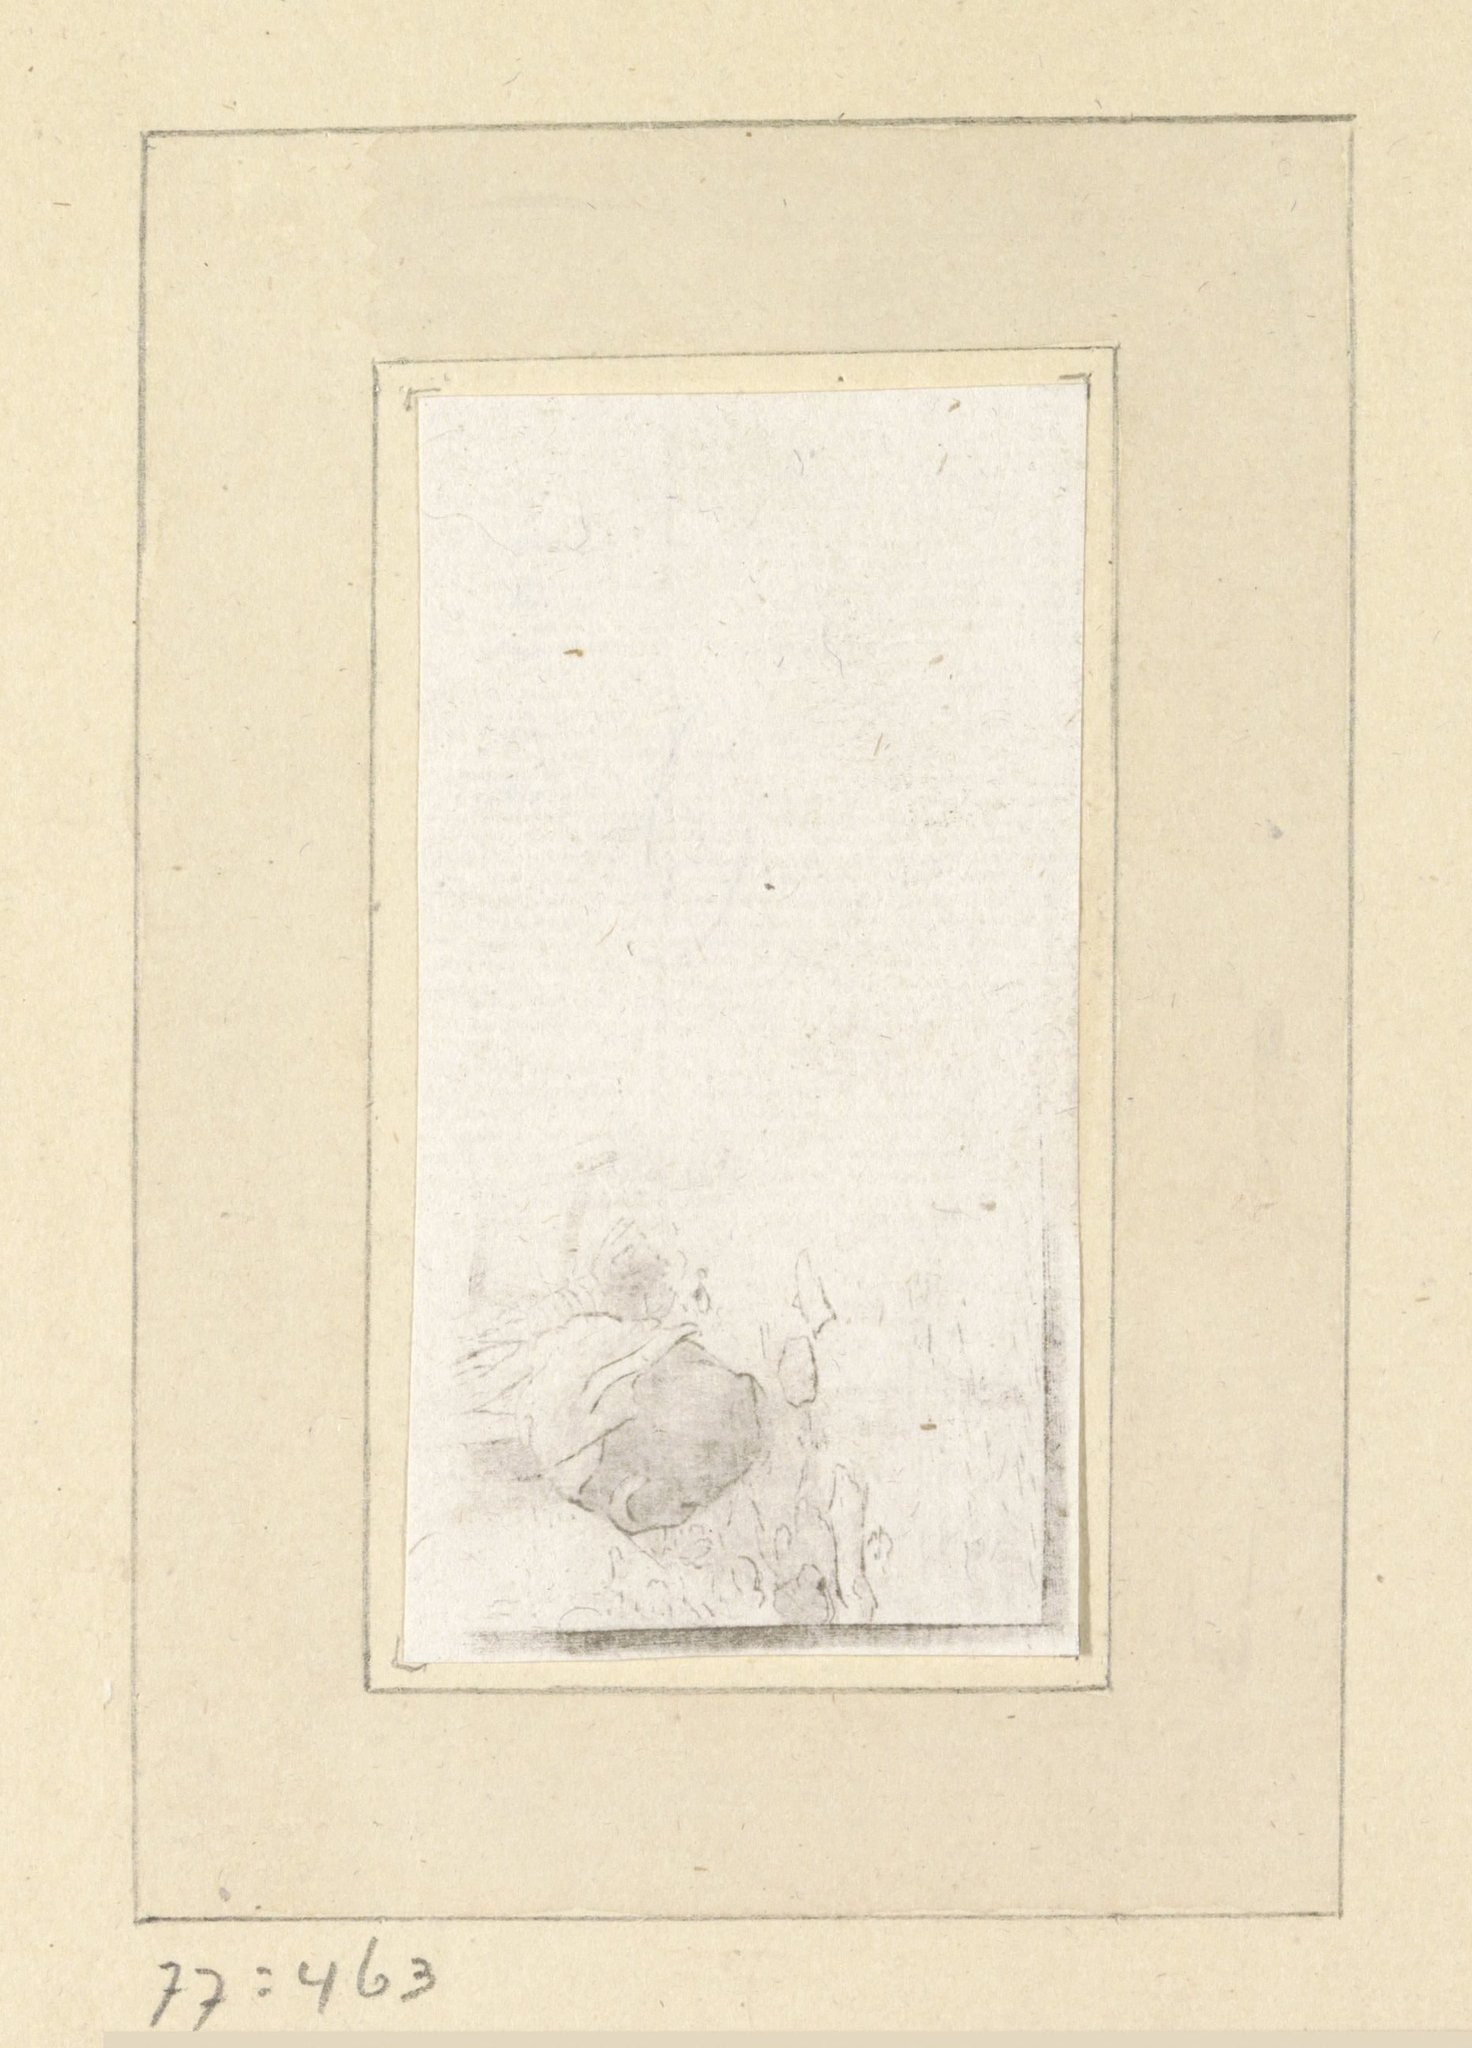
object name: print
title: Pot bij de haard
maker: cornelis ploos van amstel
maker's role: draughtsman, print maker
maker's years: 1726-1798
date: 1760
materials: paper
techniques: printmaking, etching, roulette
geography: amsterdam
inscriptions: collector's mark: Lugt 2228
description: Detail uit: Interieur met vrouw bij wieg.